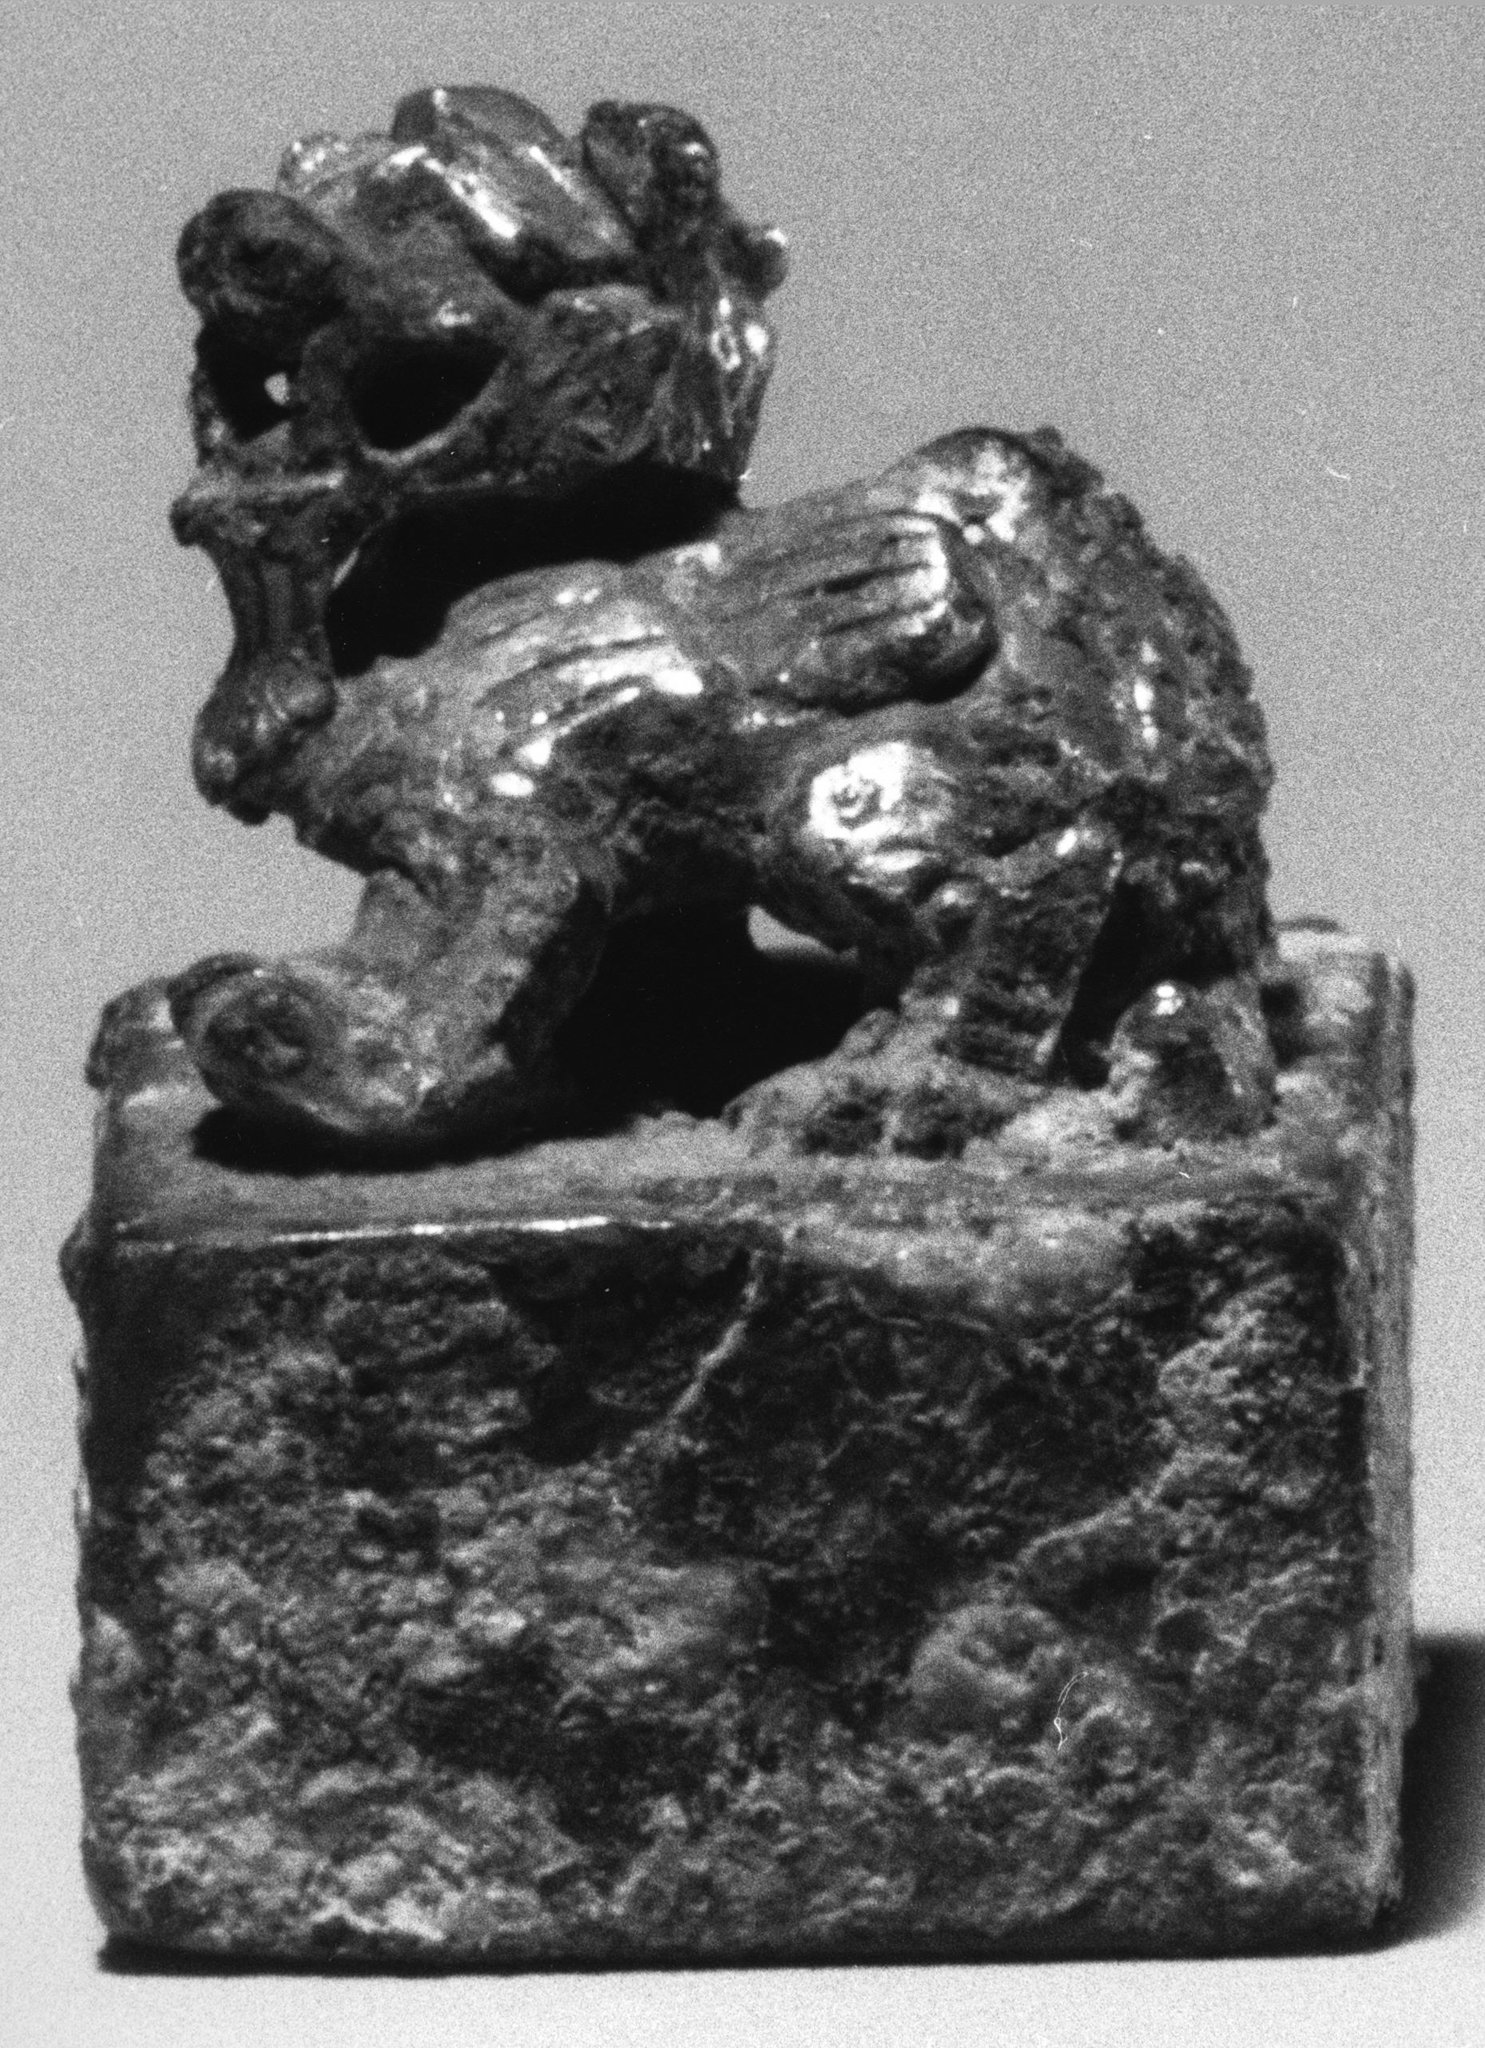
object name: seal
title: Seal with Knob in the Shape of a Chimera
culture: chinese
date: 201-300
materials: bronze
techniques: gilding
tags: mythical creatures